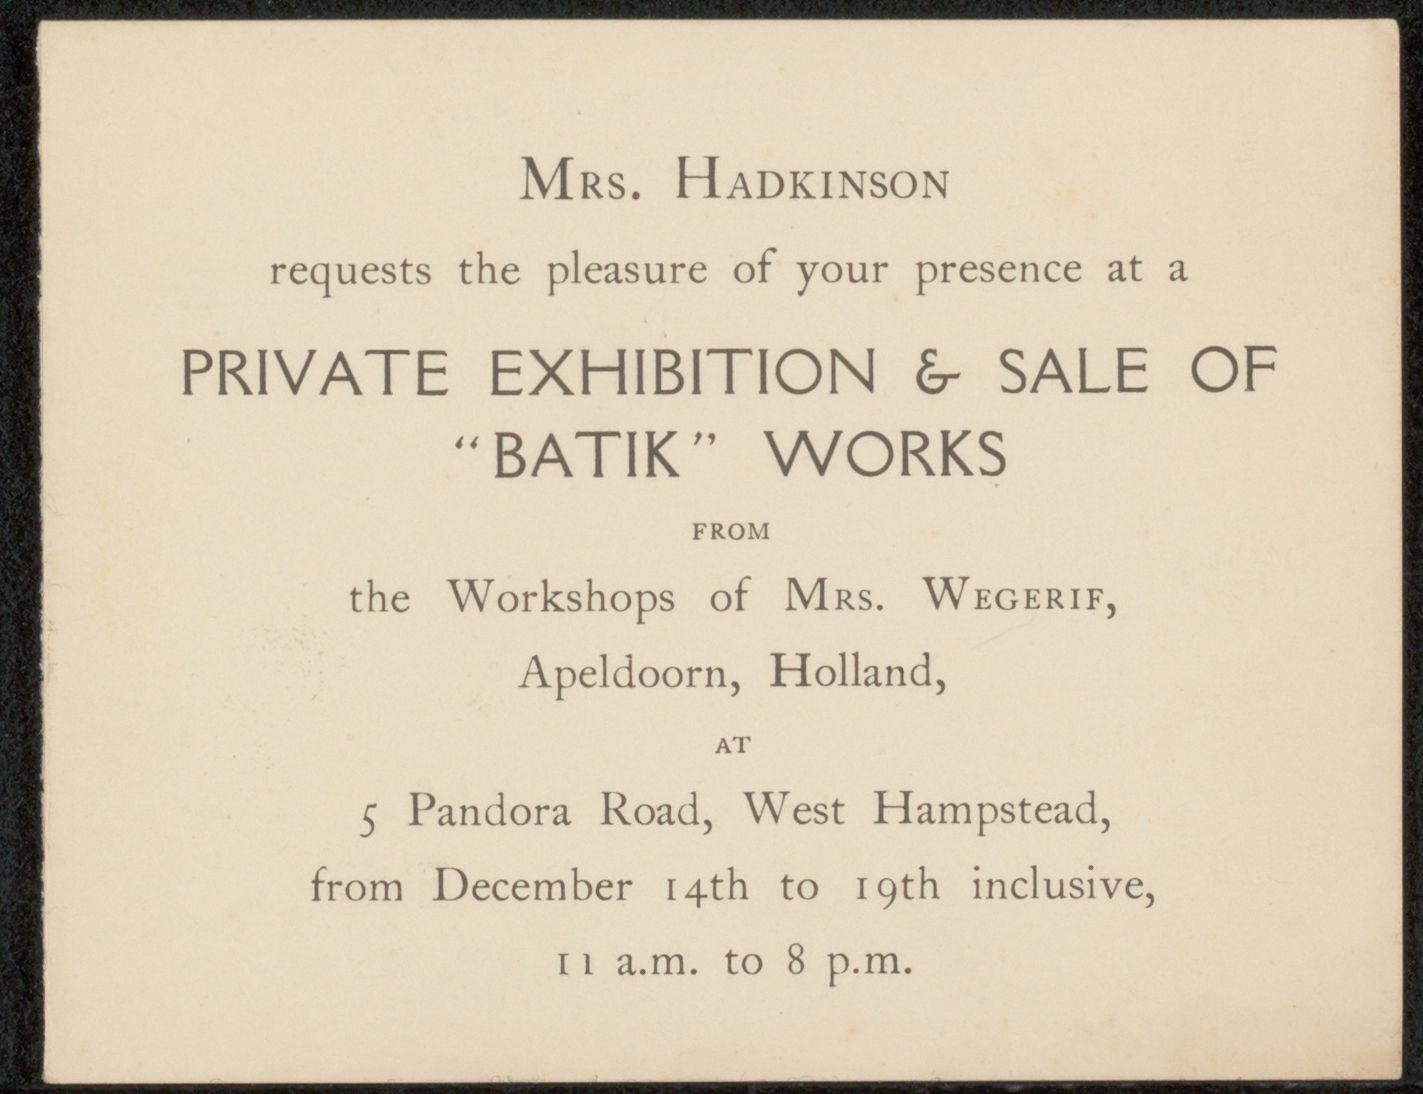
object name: invitation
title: Uitnodiging aan Philip Zilcken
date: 1873-1928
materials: cardboard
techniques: printing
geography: hampstead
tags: agathe wegerif-gravestein, the hague, painter, draughtsman, philip zilcken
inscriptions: collector's mark: ‘RPK’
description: Bijgevoegd een gedrukte kaart met lofuitingen.